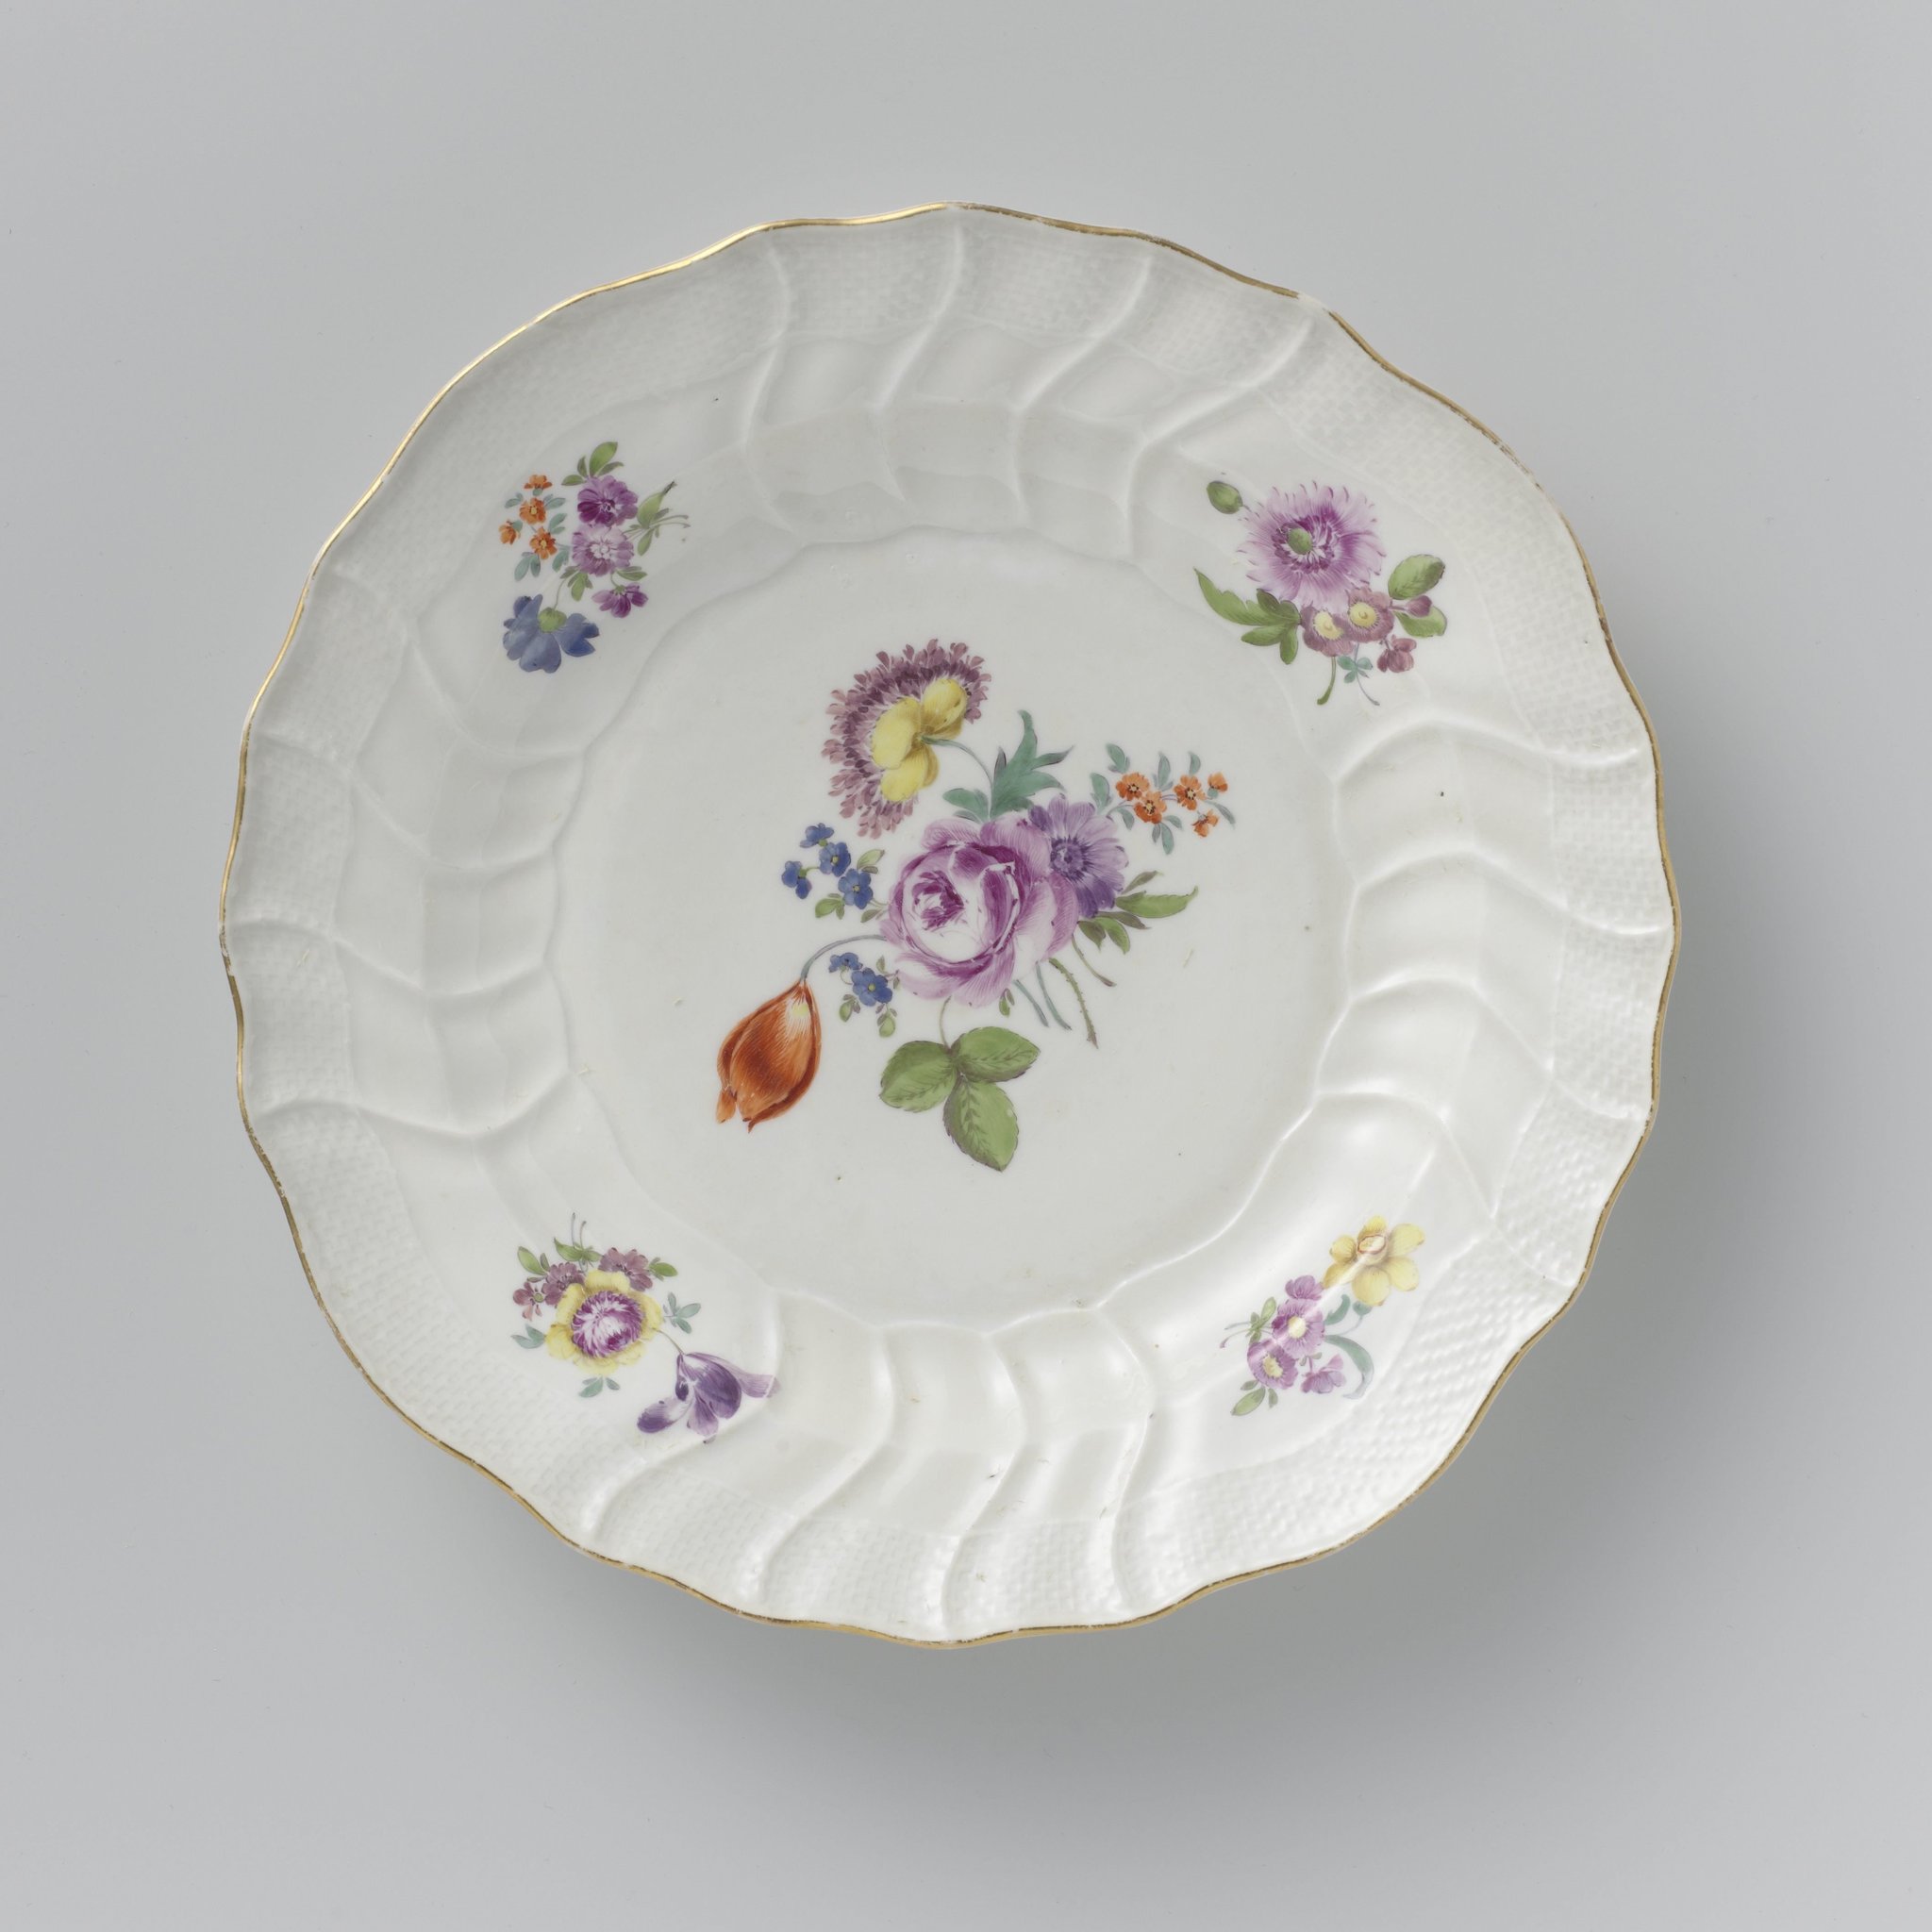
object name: plate dish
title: Bord, veelkleurig beschilderd met Deutsche Blumen, insekten en vruchten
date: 1750-1760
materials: porcelain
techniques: painted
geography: meissen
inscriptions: factory mark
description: Rond bord van beschilderd porselein. De rand is versierd met het Neuozier-patroon in reliëf. De beschildering bestaat uit Deutsche Blumen, insekten en vruchten. Het bord is gemerkt en hoort bij een servies (BK-17474-1 t/m BK-17474-253).